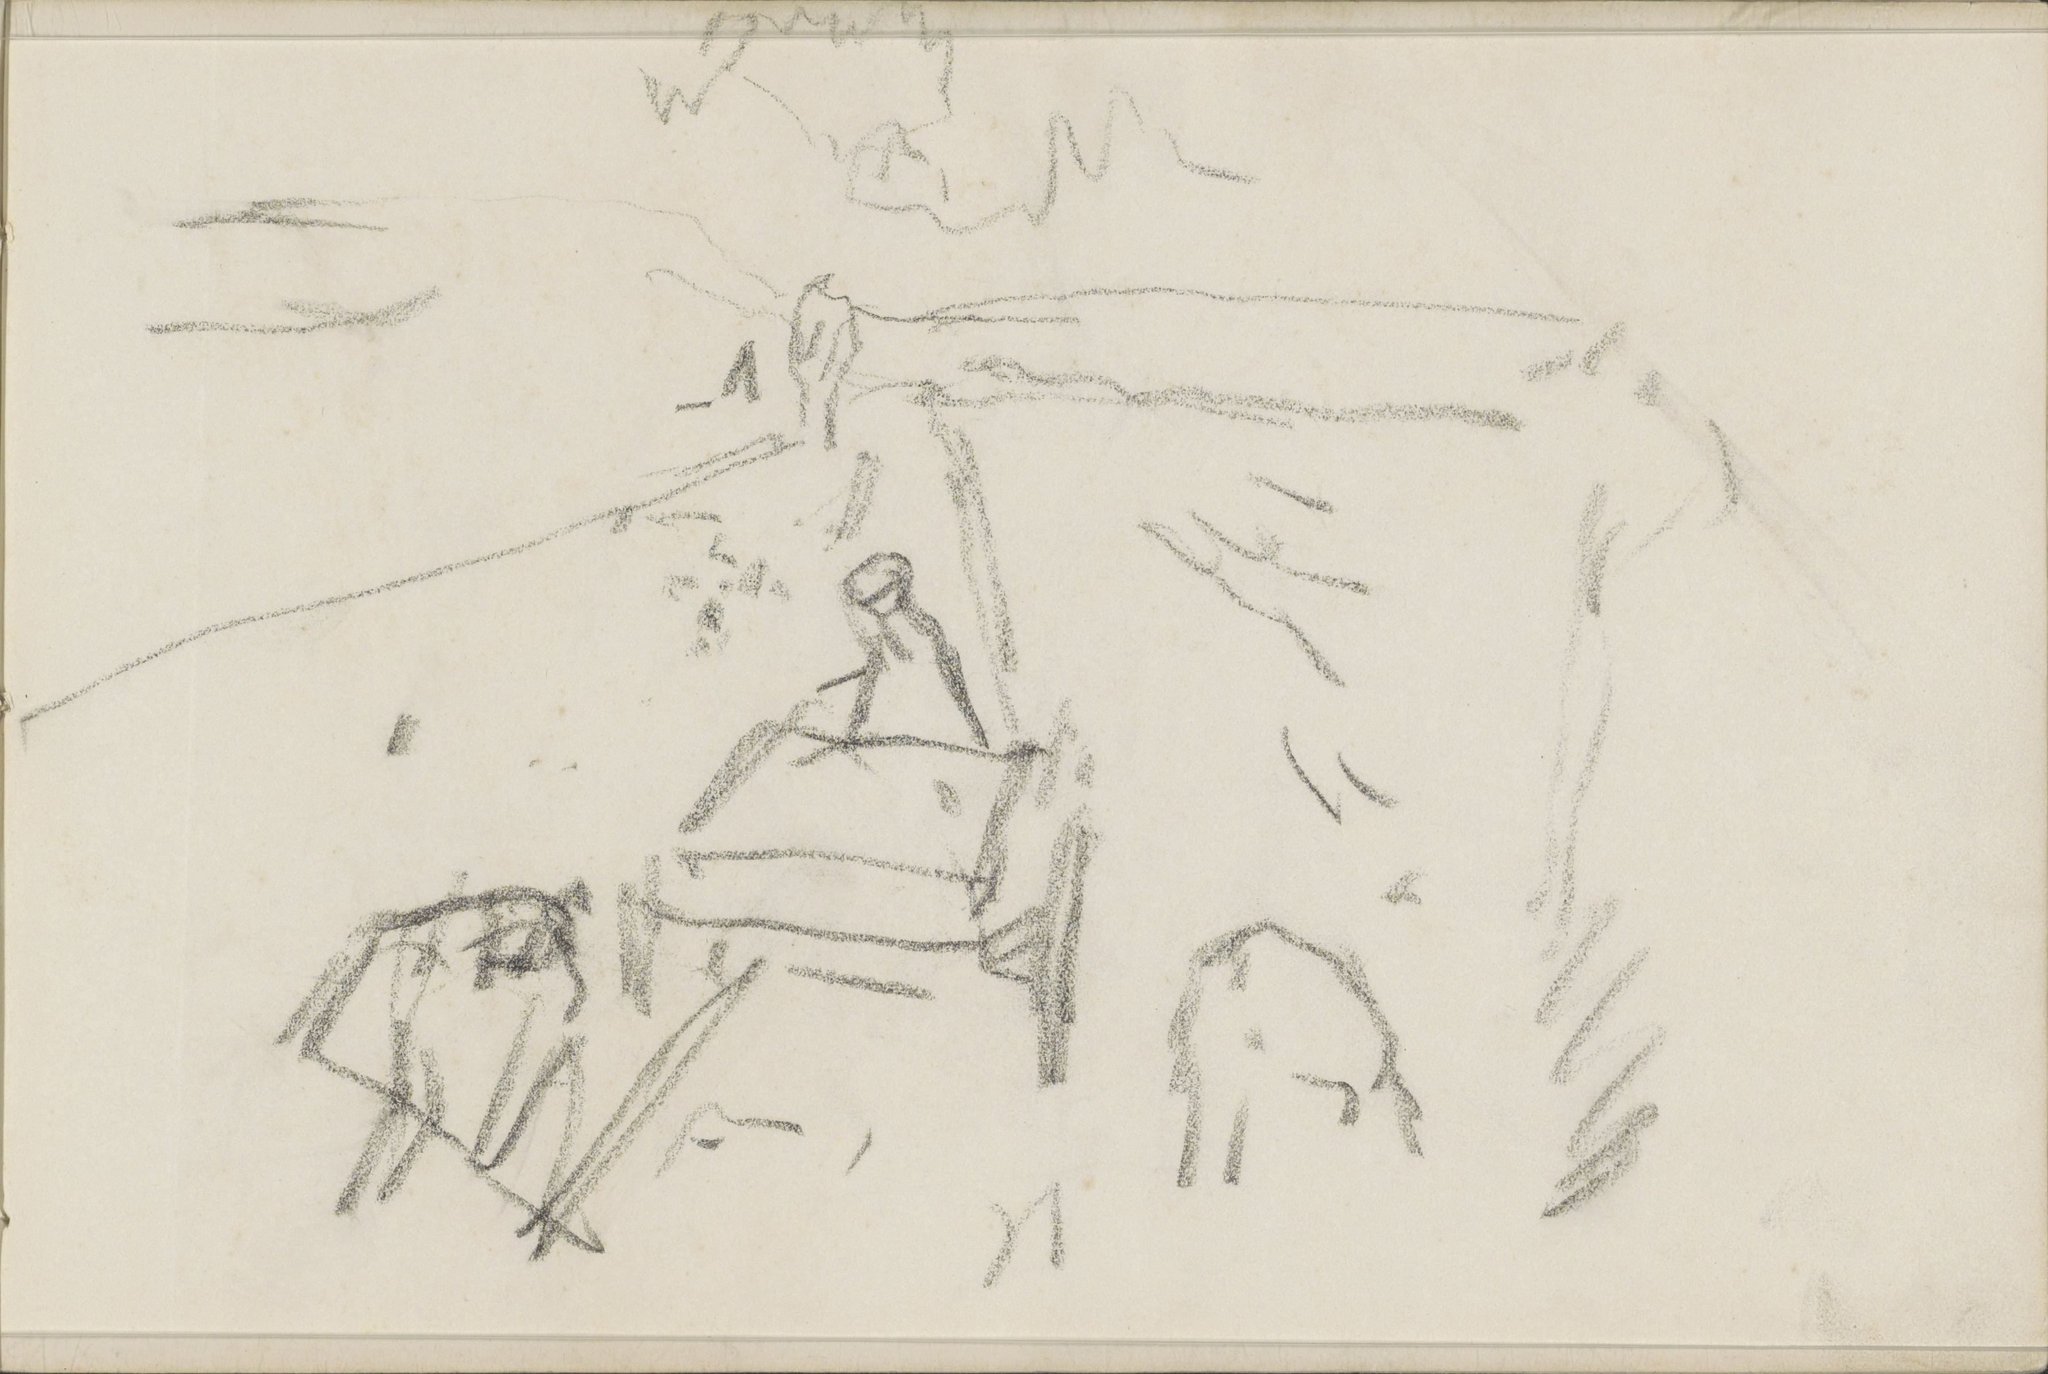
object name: sketchbook leaf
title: Figuren bij een kar, mogelijk op het platteland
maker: george hendrik breitner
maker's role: draughtsman, painter, print maker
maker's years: 1857-1923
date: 1886-1923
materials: chalk, paper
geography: amsterdam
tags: cultivated land (+ landscape with figures, staffage), (farm) wagon, freight wagon, cart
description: Pagina 2 uit een schetsboek met 14 bladen.